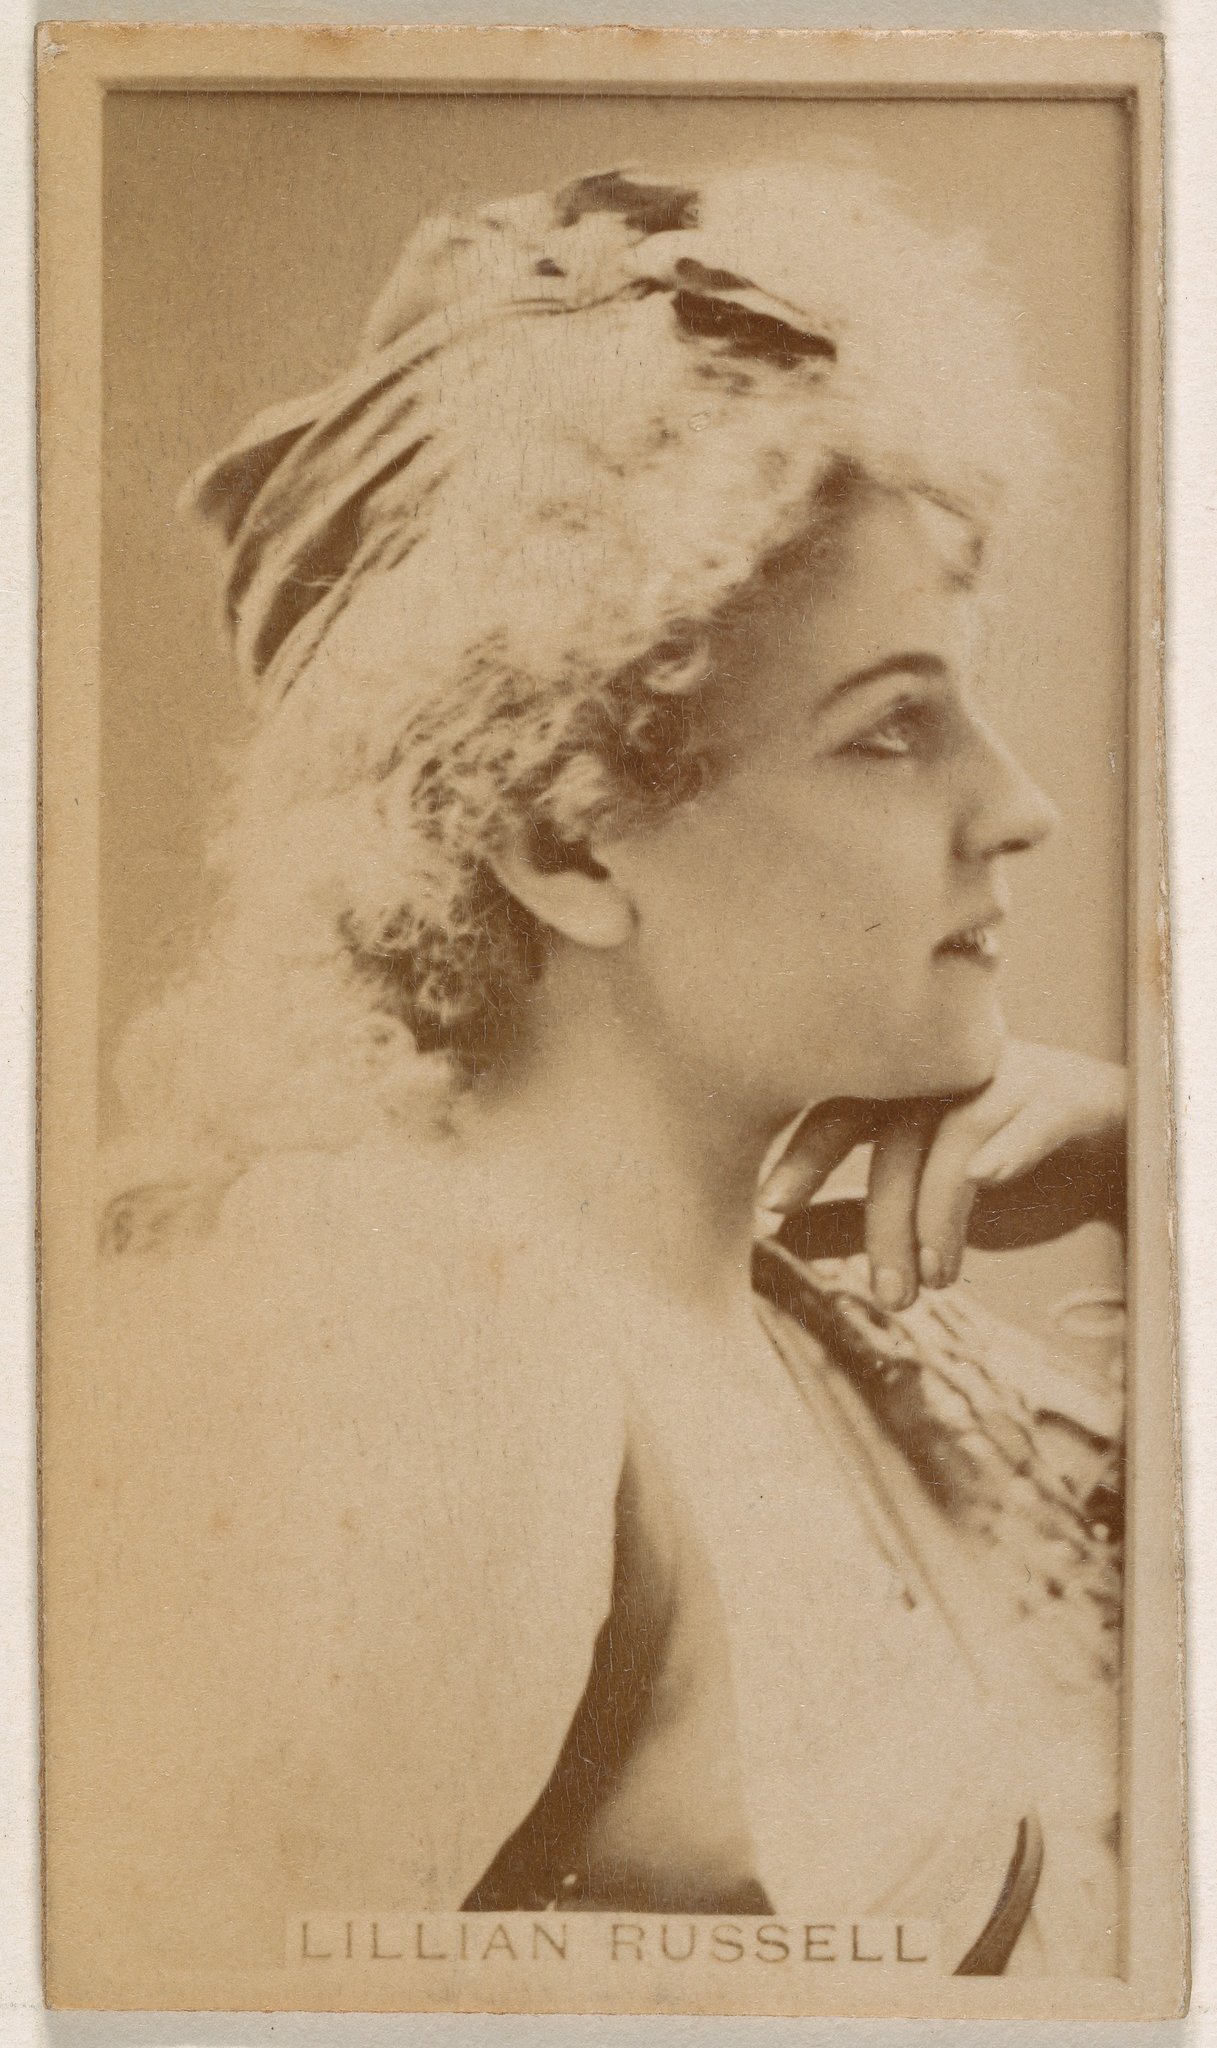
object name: photograph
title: Lillian Russell, from the Actresses series (N245) issued by Kinney Brothers to promote Sweet Caporal Cigarettes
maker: kinney brothers tobacco company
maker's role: publisher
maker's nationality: american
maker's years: 1869-2011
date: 1890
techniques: albumen silver print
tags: women,actresses